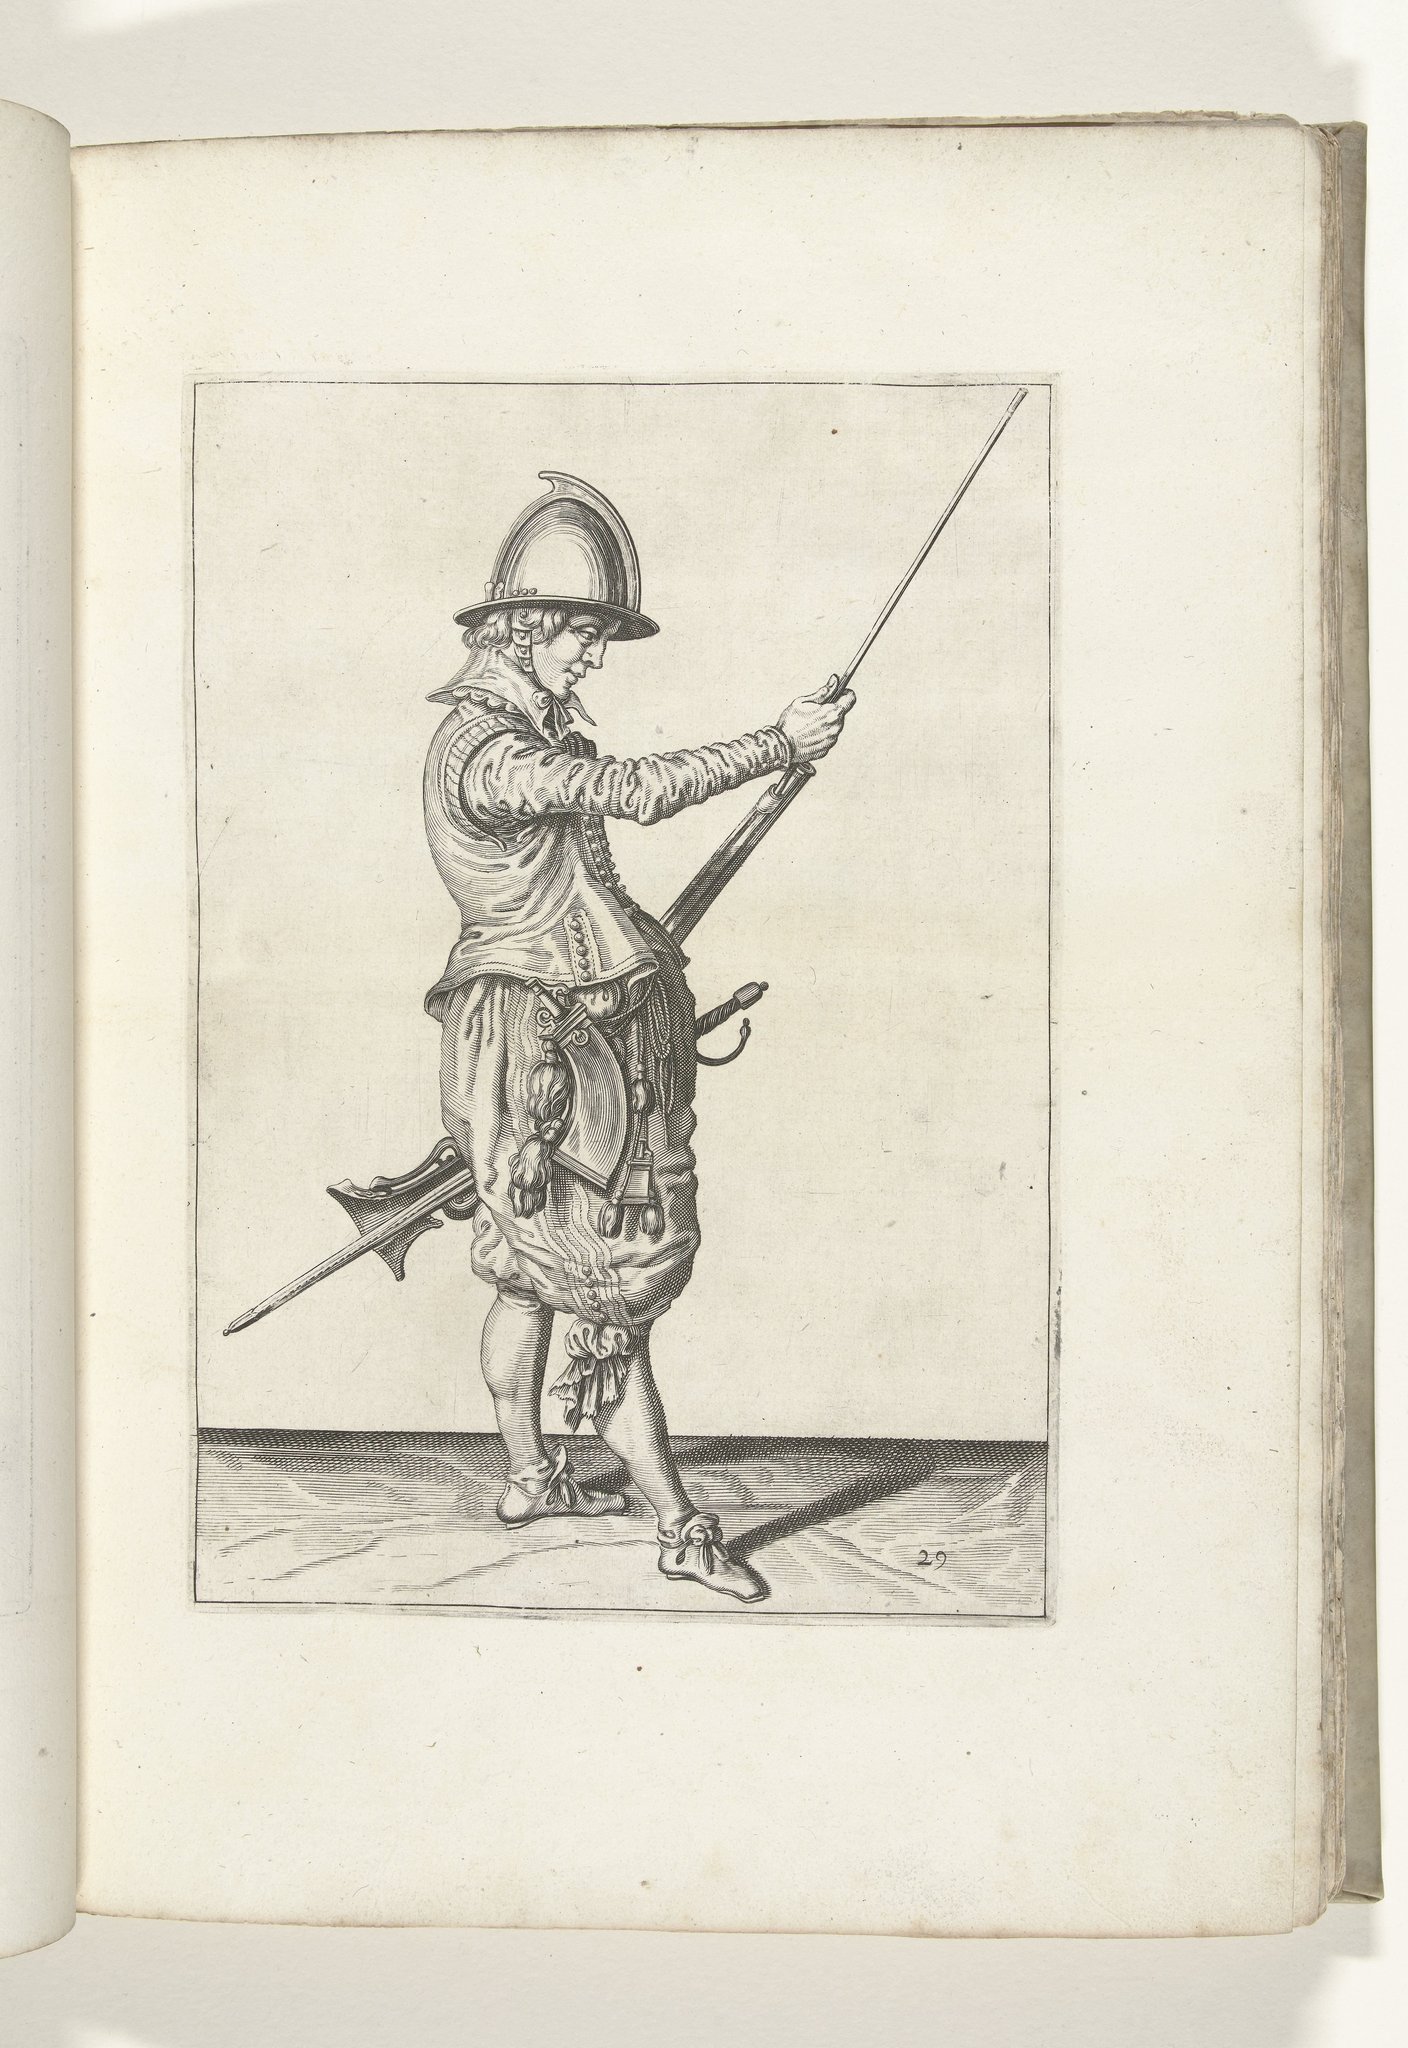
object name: print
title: Soldaat die zijn laadstok in de houder onder de loop van zijn roer schuift (nr. 29), ca. 1600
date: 1597-1607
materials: paper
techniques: engraving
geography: northern netherlands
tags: the hague, maurice (prince of orange), handling of weapons ~ military training, weapons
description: Een soldaat, ten voeten uit, naar rechts, die met zijn linkerhand bij zijn linkerdijbeen een roer (een bepaald type vuurwapen) vasthoudt en met zijn rechterhand de laadstok in de houder onder de loop schuift (nr. 29), ca. 1600. Plaat 29 in de instructies voor het hanteren van de roer: Corte onderwysinghe op de figuerliicke afbeeldinghe, belanghende t'rechte ghebruyck des Roers. Onderdeel van de illustraties in: J. de Gheyn, Wapenhandelinghe van Roers Musquetten ende spiessen, 's-Gravenhage, 1607. Krijgswezen rond 1600.